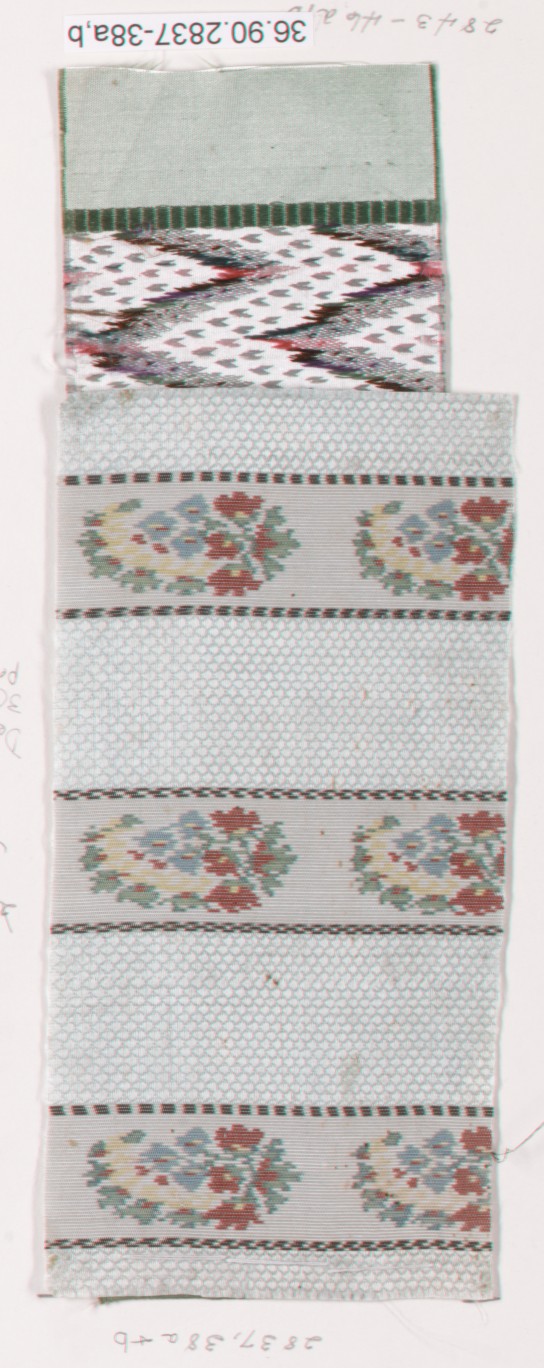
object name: piece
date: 1801-1900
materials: silk